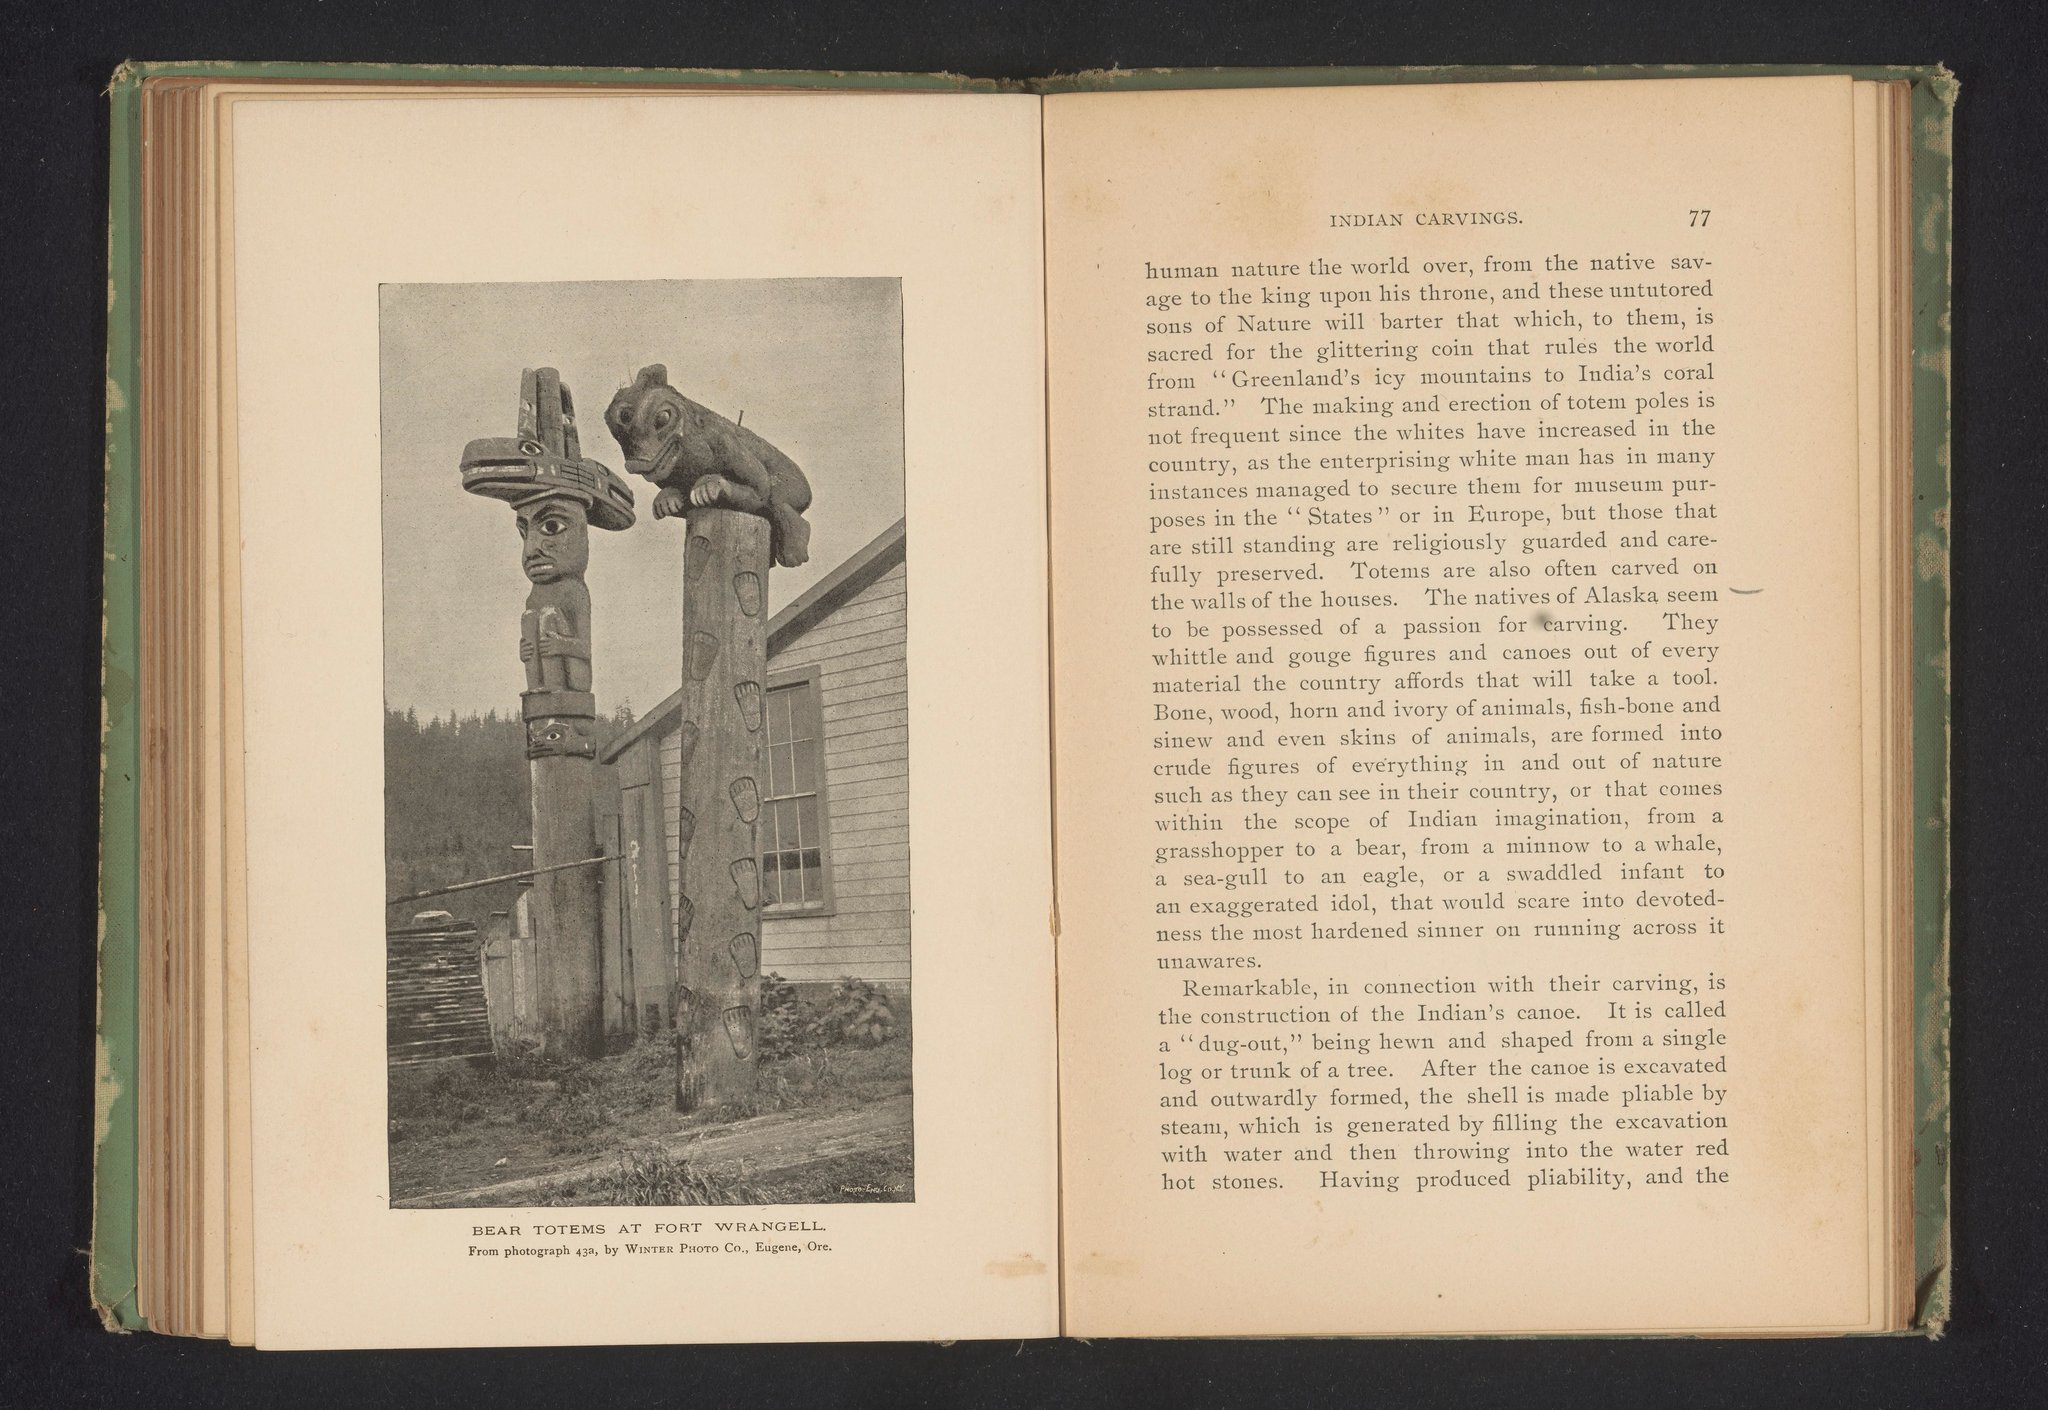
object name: page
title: Twee totempalen met beren in Wrangell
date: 1885-1890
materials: paper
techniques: autotype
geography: new york city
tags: monument, statue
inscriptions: inscription: ‘From photograph 43a, by Winter Photo Co., Eugene, Ore.’